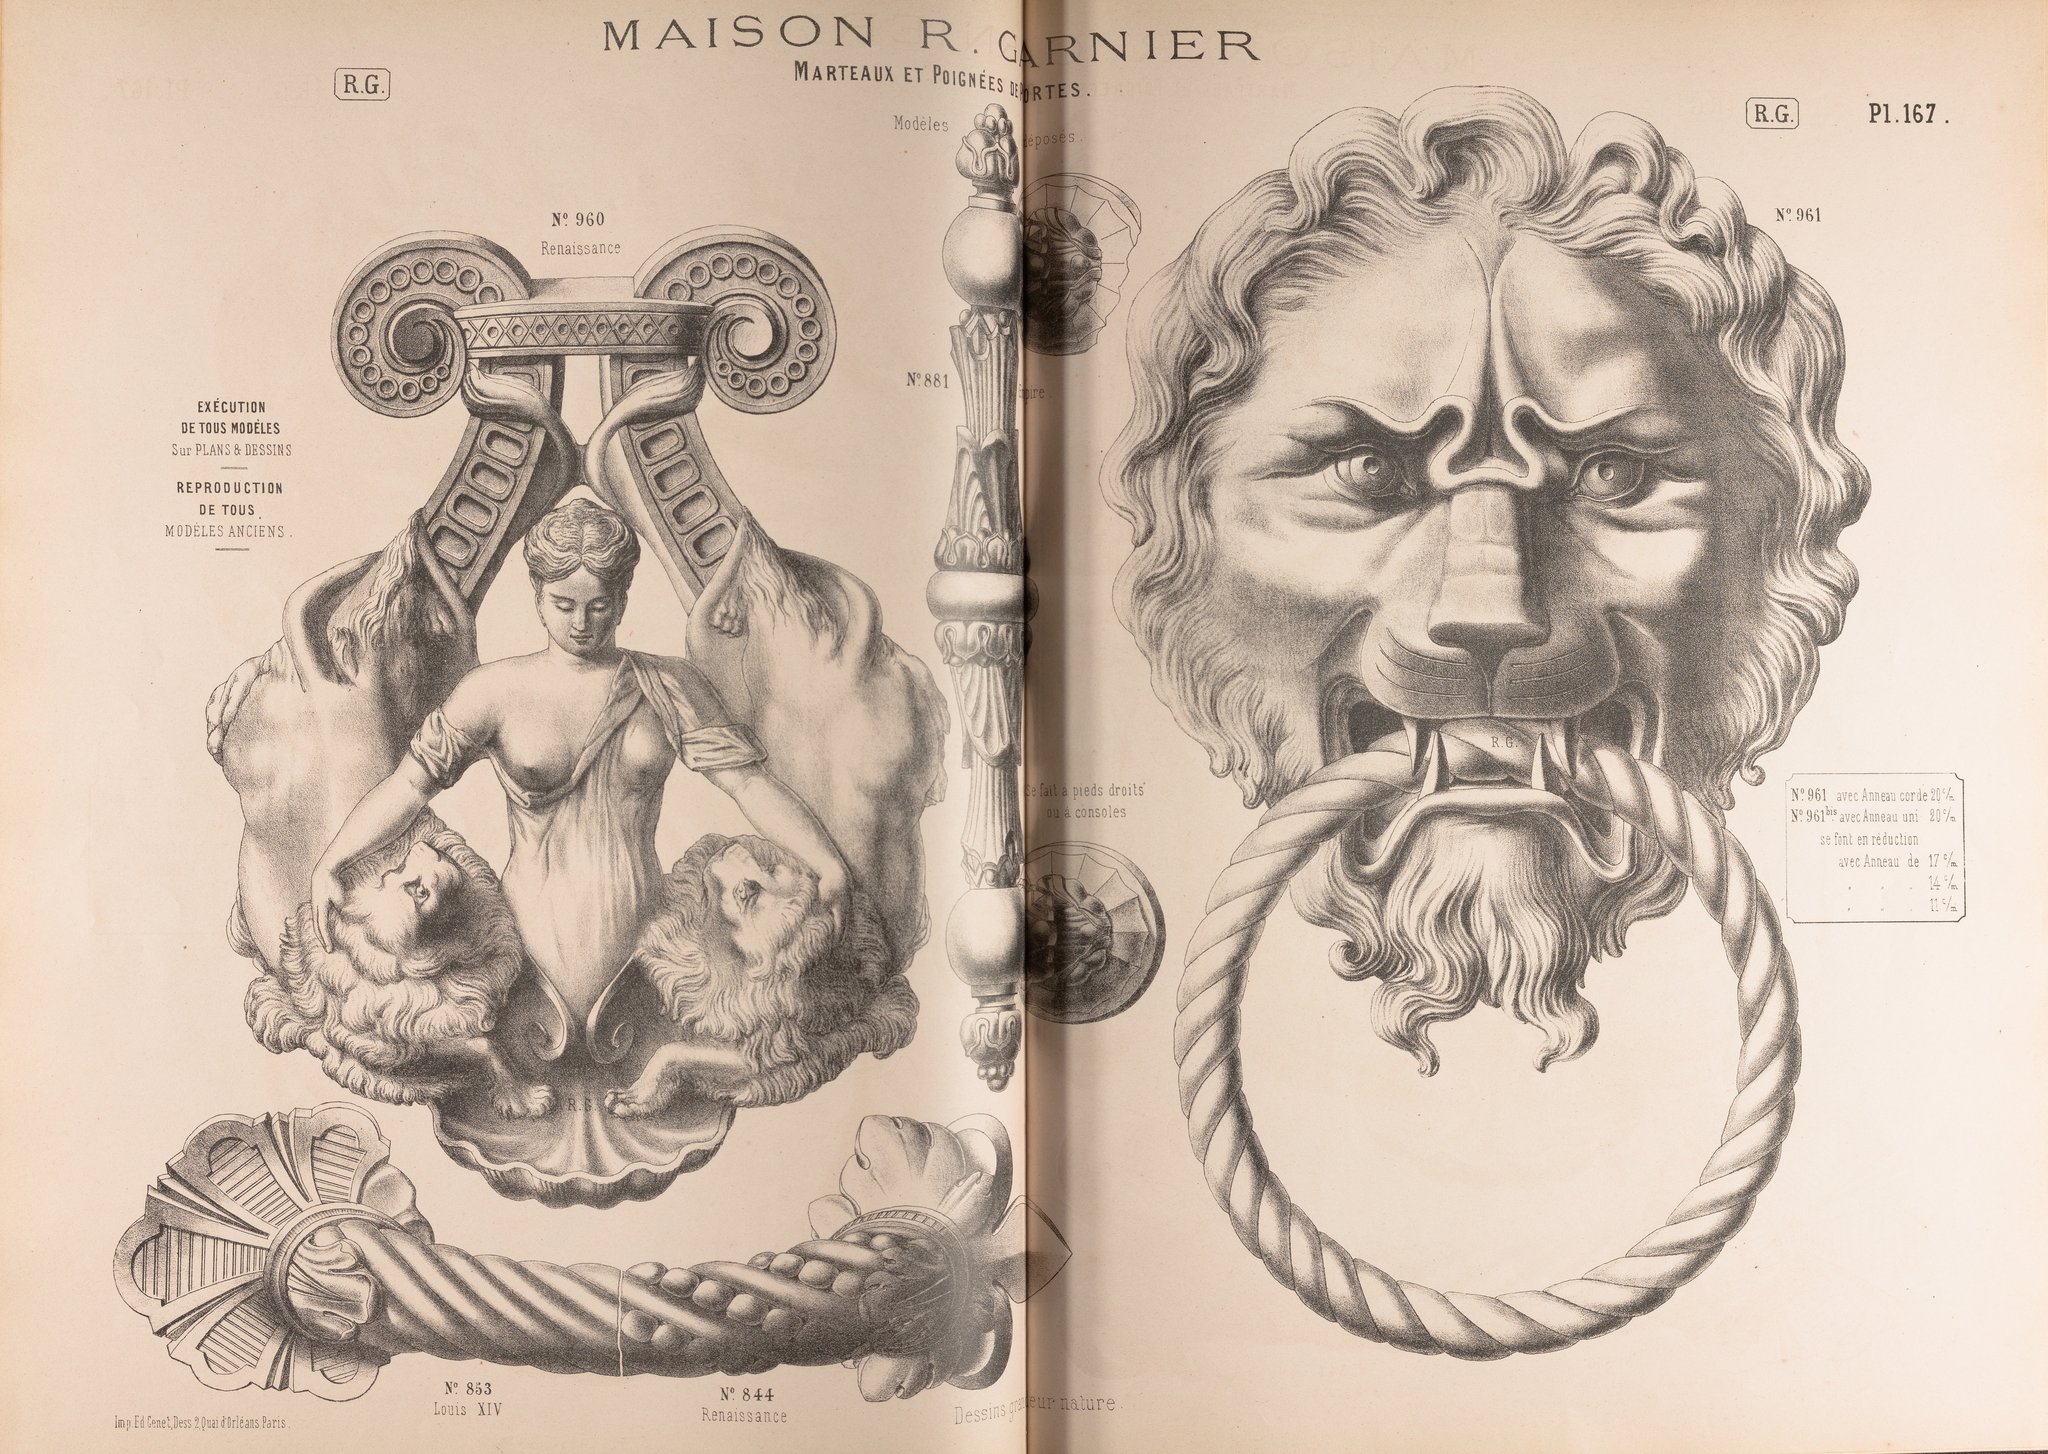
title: Maison R. Garnier, Brun-Cottan frères successeurs ... Paris : cuivrerie et serrurerie artistiques ..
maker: maison r. garnier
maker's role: publisher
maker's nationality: french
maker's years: 1832-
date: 1880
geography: france